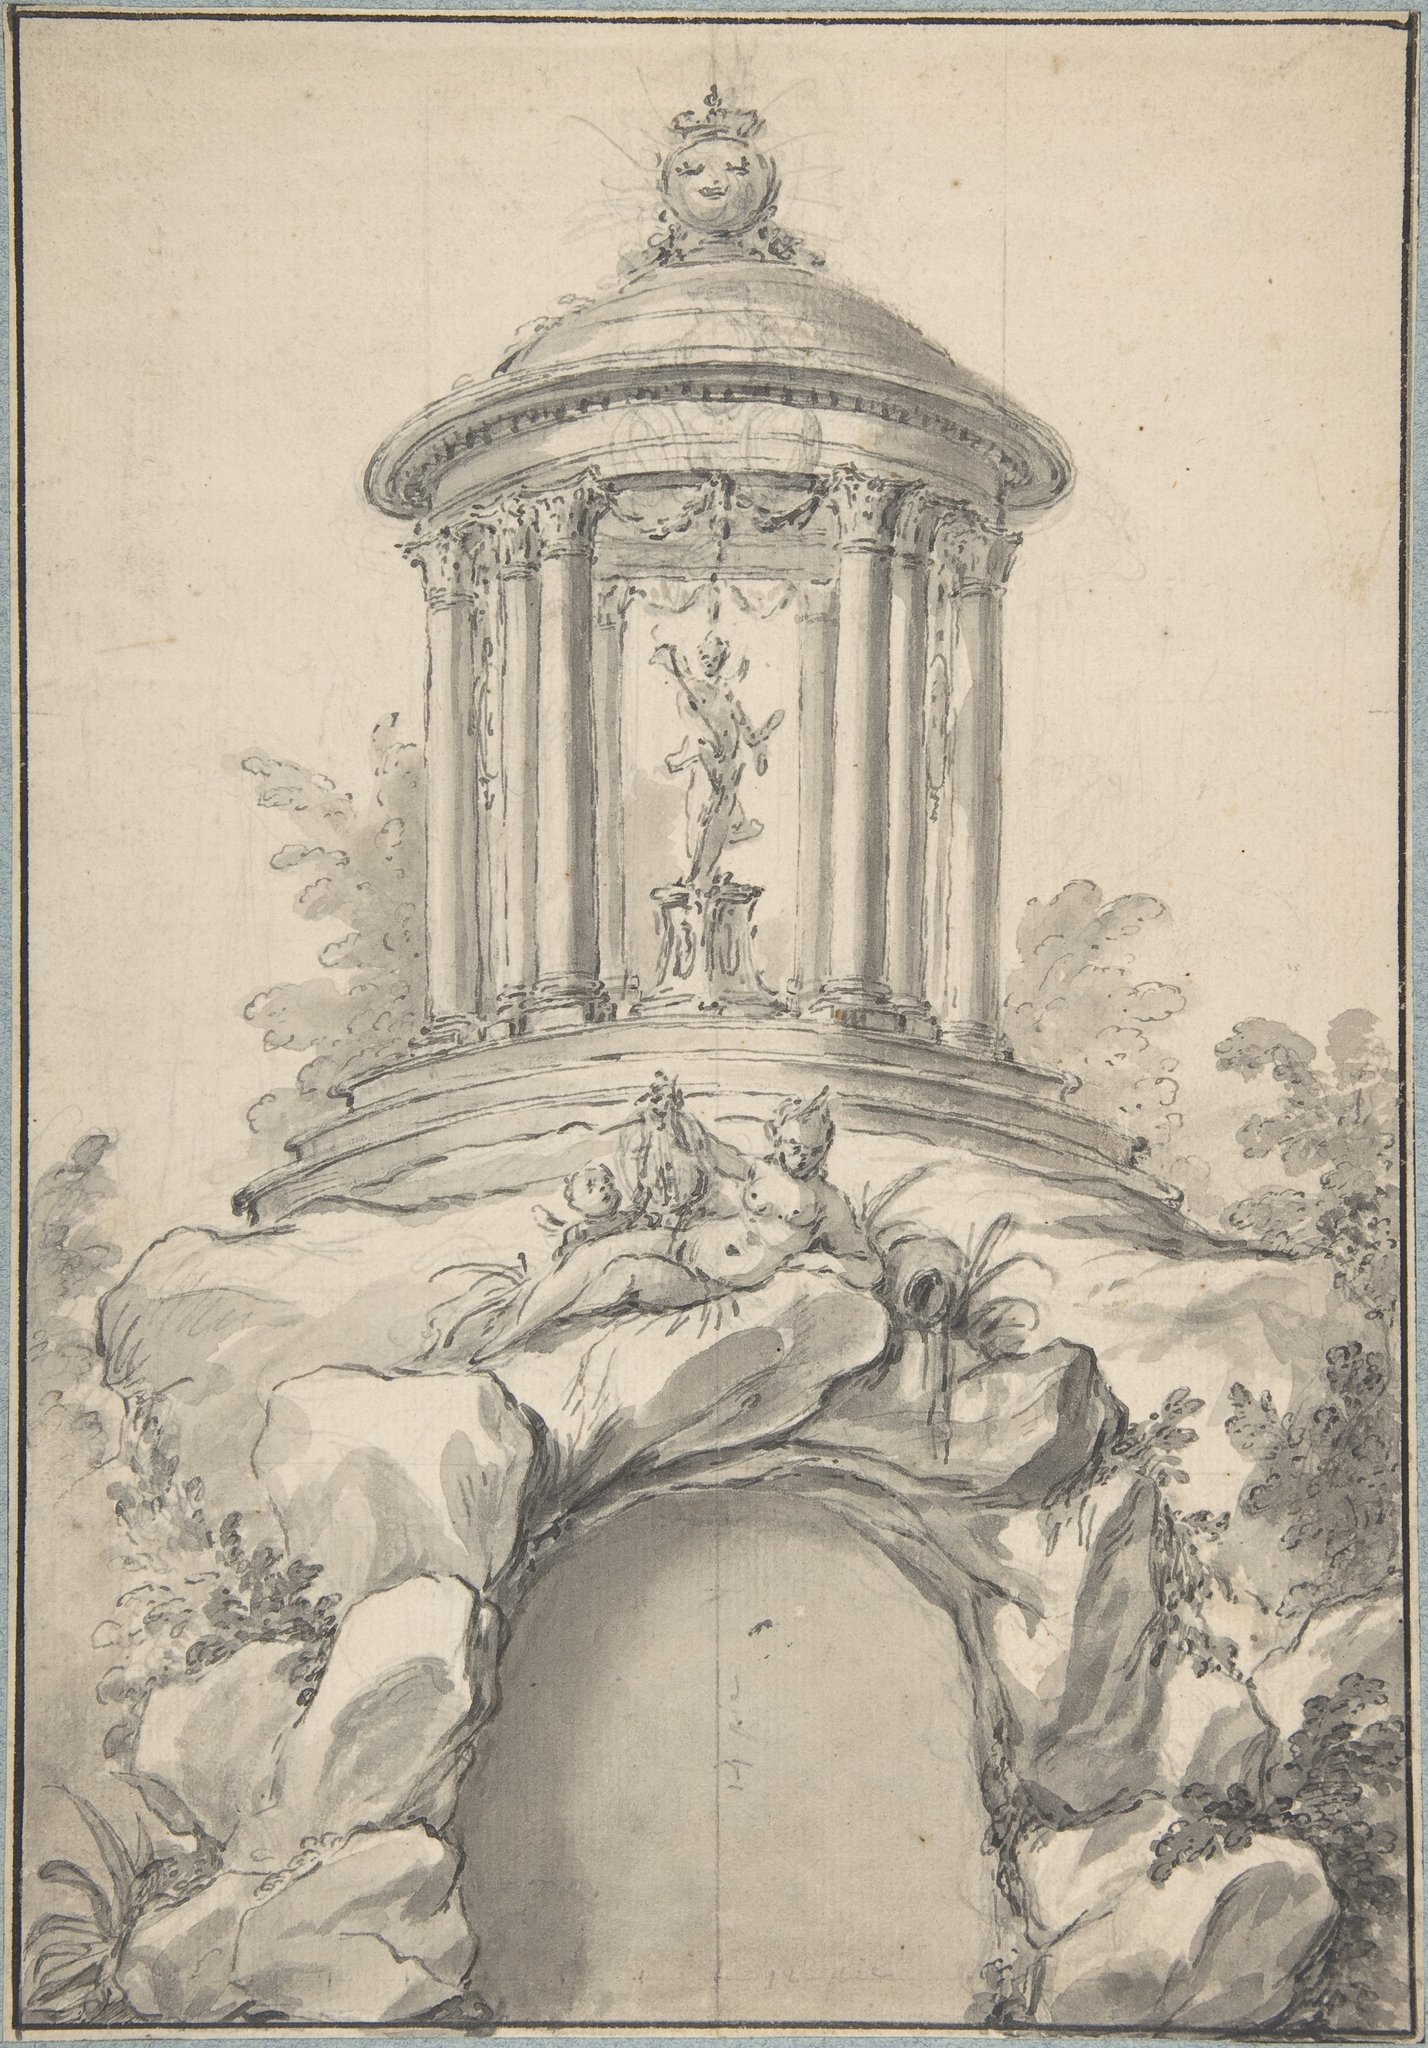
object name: drawing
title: Design for Festival Architecture for an Entry into Paris for the King of Sweden, Frederick I of Hesse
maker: guillaume thomas raphaël taraval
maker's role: artist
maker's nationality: french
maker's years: 1701-1750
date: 1701-1800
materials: chalk, ink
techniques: pen, wash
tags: architecture,temples